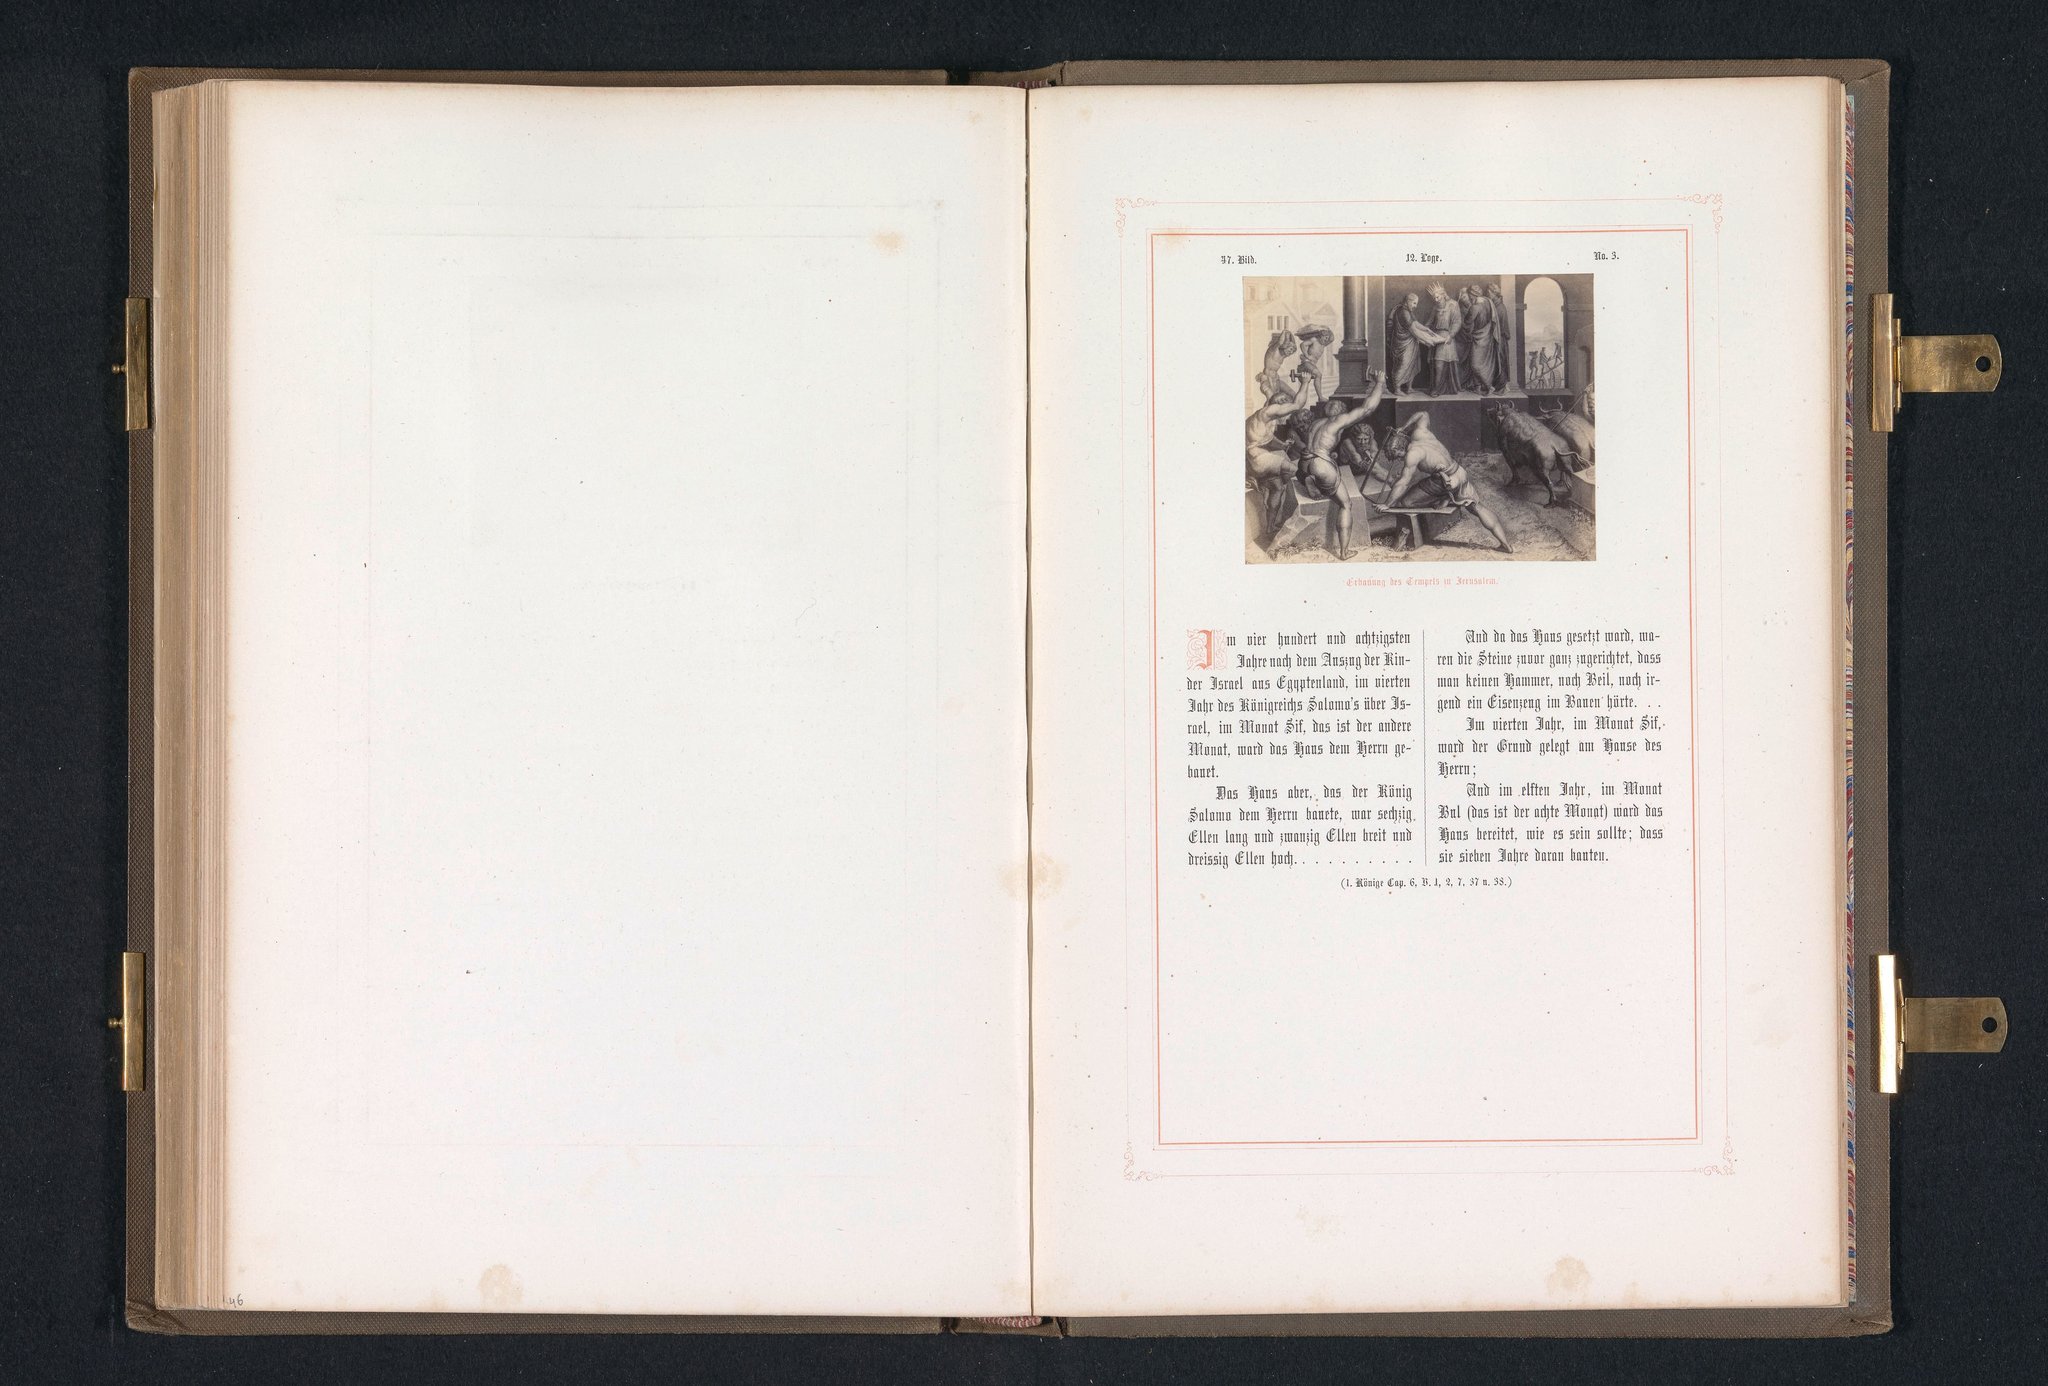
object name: page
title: Der Richterspruch Salomo's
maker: gustav schauer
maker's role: painter, publisher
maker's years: 1826-1902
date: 1851-1861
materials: photographic support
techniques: albumen print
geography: berlin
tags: the judgement of solomon (1 kings 3:16-28)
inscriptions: inscription: ‘46. Bild. 12. Loge. No. 2.’